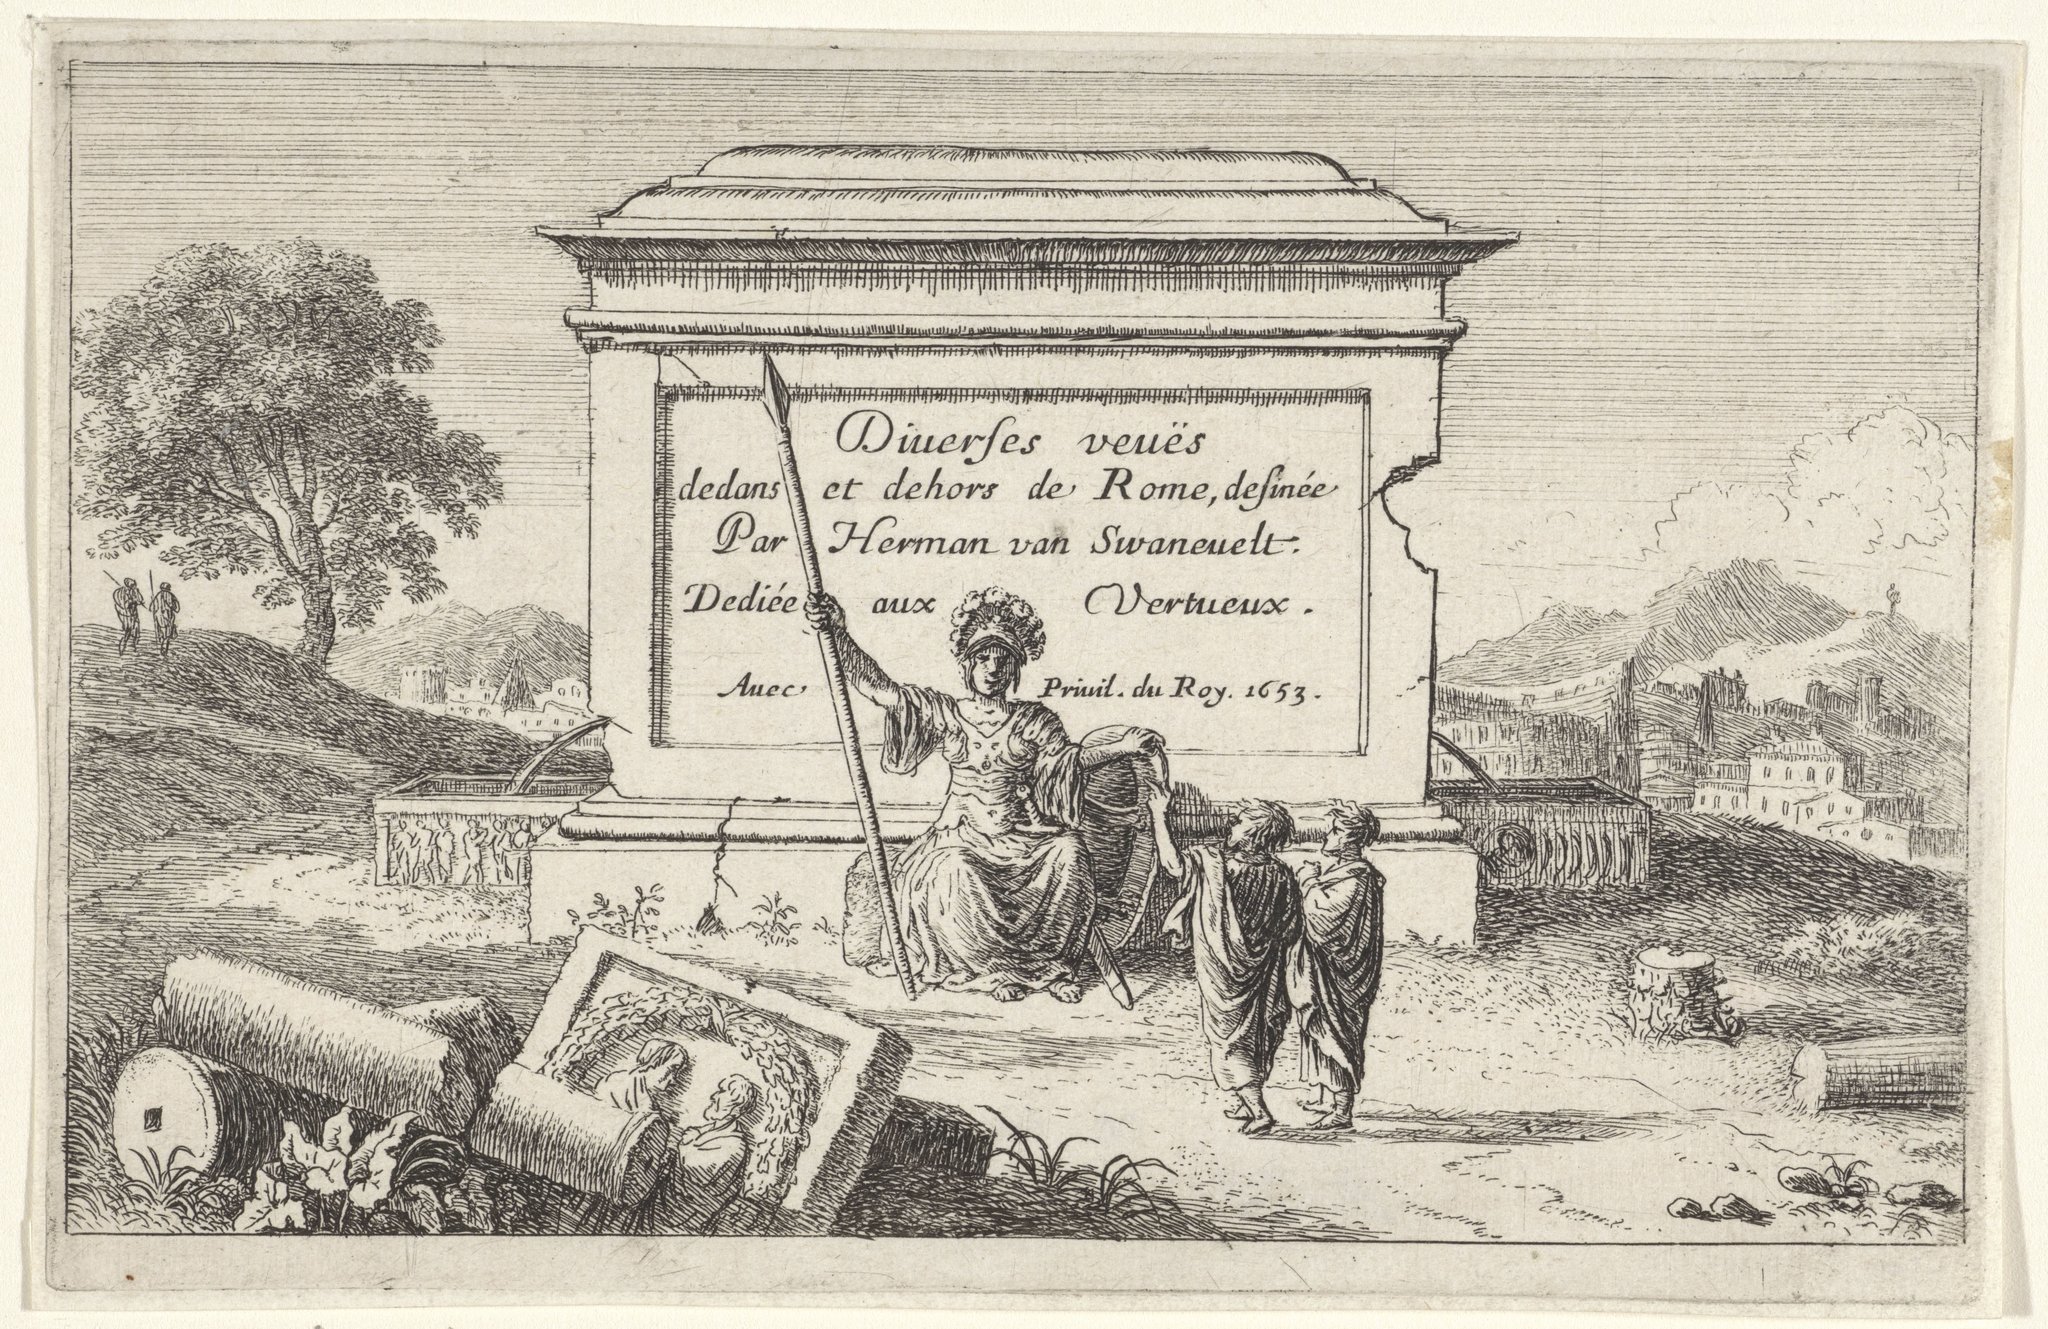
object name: titelprent, frontispice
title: Minerva gezeten voor een sokkel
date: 1653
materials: paper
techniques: etching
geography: paris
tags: city-view, and landscape with man-made constructions, pedestal of a piece of sculpture (perhaps in the form of a herm), attributes of minerva, specific aspects, allegorical aspects of minerva; minerva as patroness, rome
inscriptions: collector's mark: Lugt 240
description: Voor een sokkel met een inscriptie zit Minerva met een speer, een helm en een schild. Voor haar staan twee figuren en op de grond liggen gebroken zuilen bij een basrelief met twee mannelijke bustes en een guirlande. In de verte ligt Rome. De serie is opgedragen aan 'Vertueux', de deugdzame.